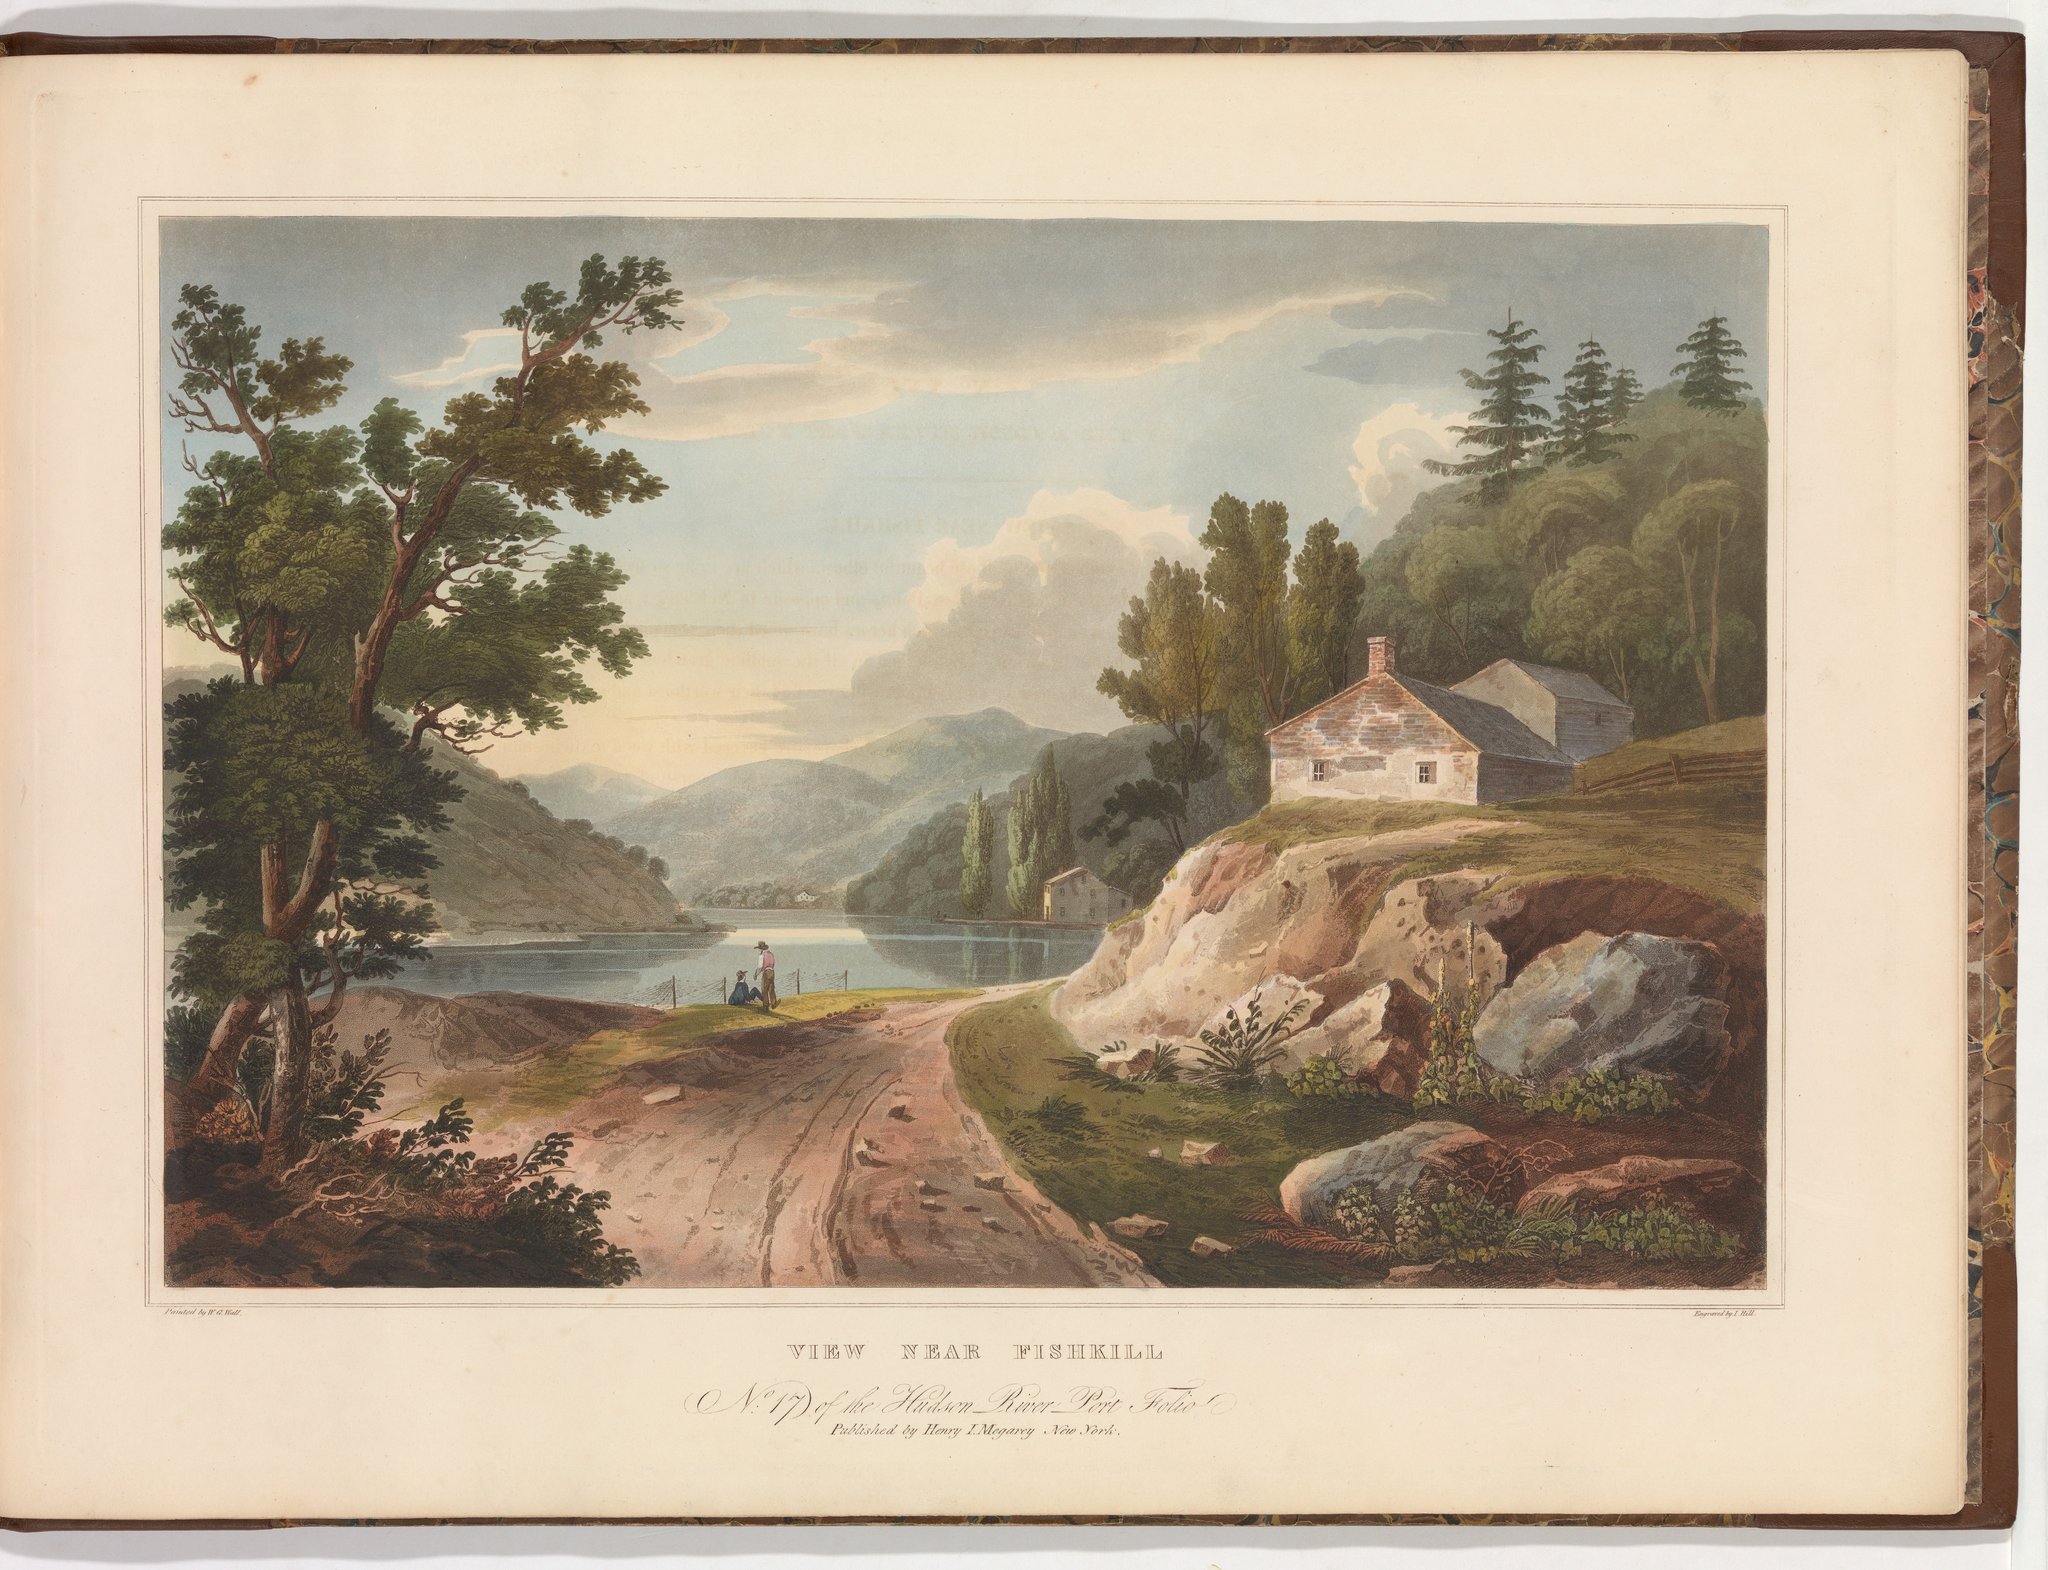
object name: print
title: View Near Fishkill (No. 17 of The Hudson River Portfolio)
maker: john hill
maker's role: etcher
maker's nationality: american, born england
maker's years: 1770-1850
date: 1823-1824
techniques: aquatint, hand coloring, printing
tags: houses,rivers,landscapes,trees